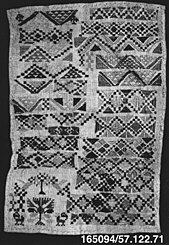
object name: sampler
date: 1801-1900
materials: cotton